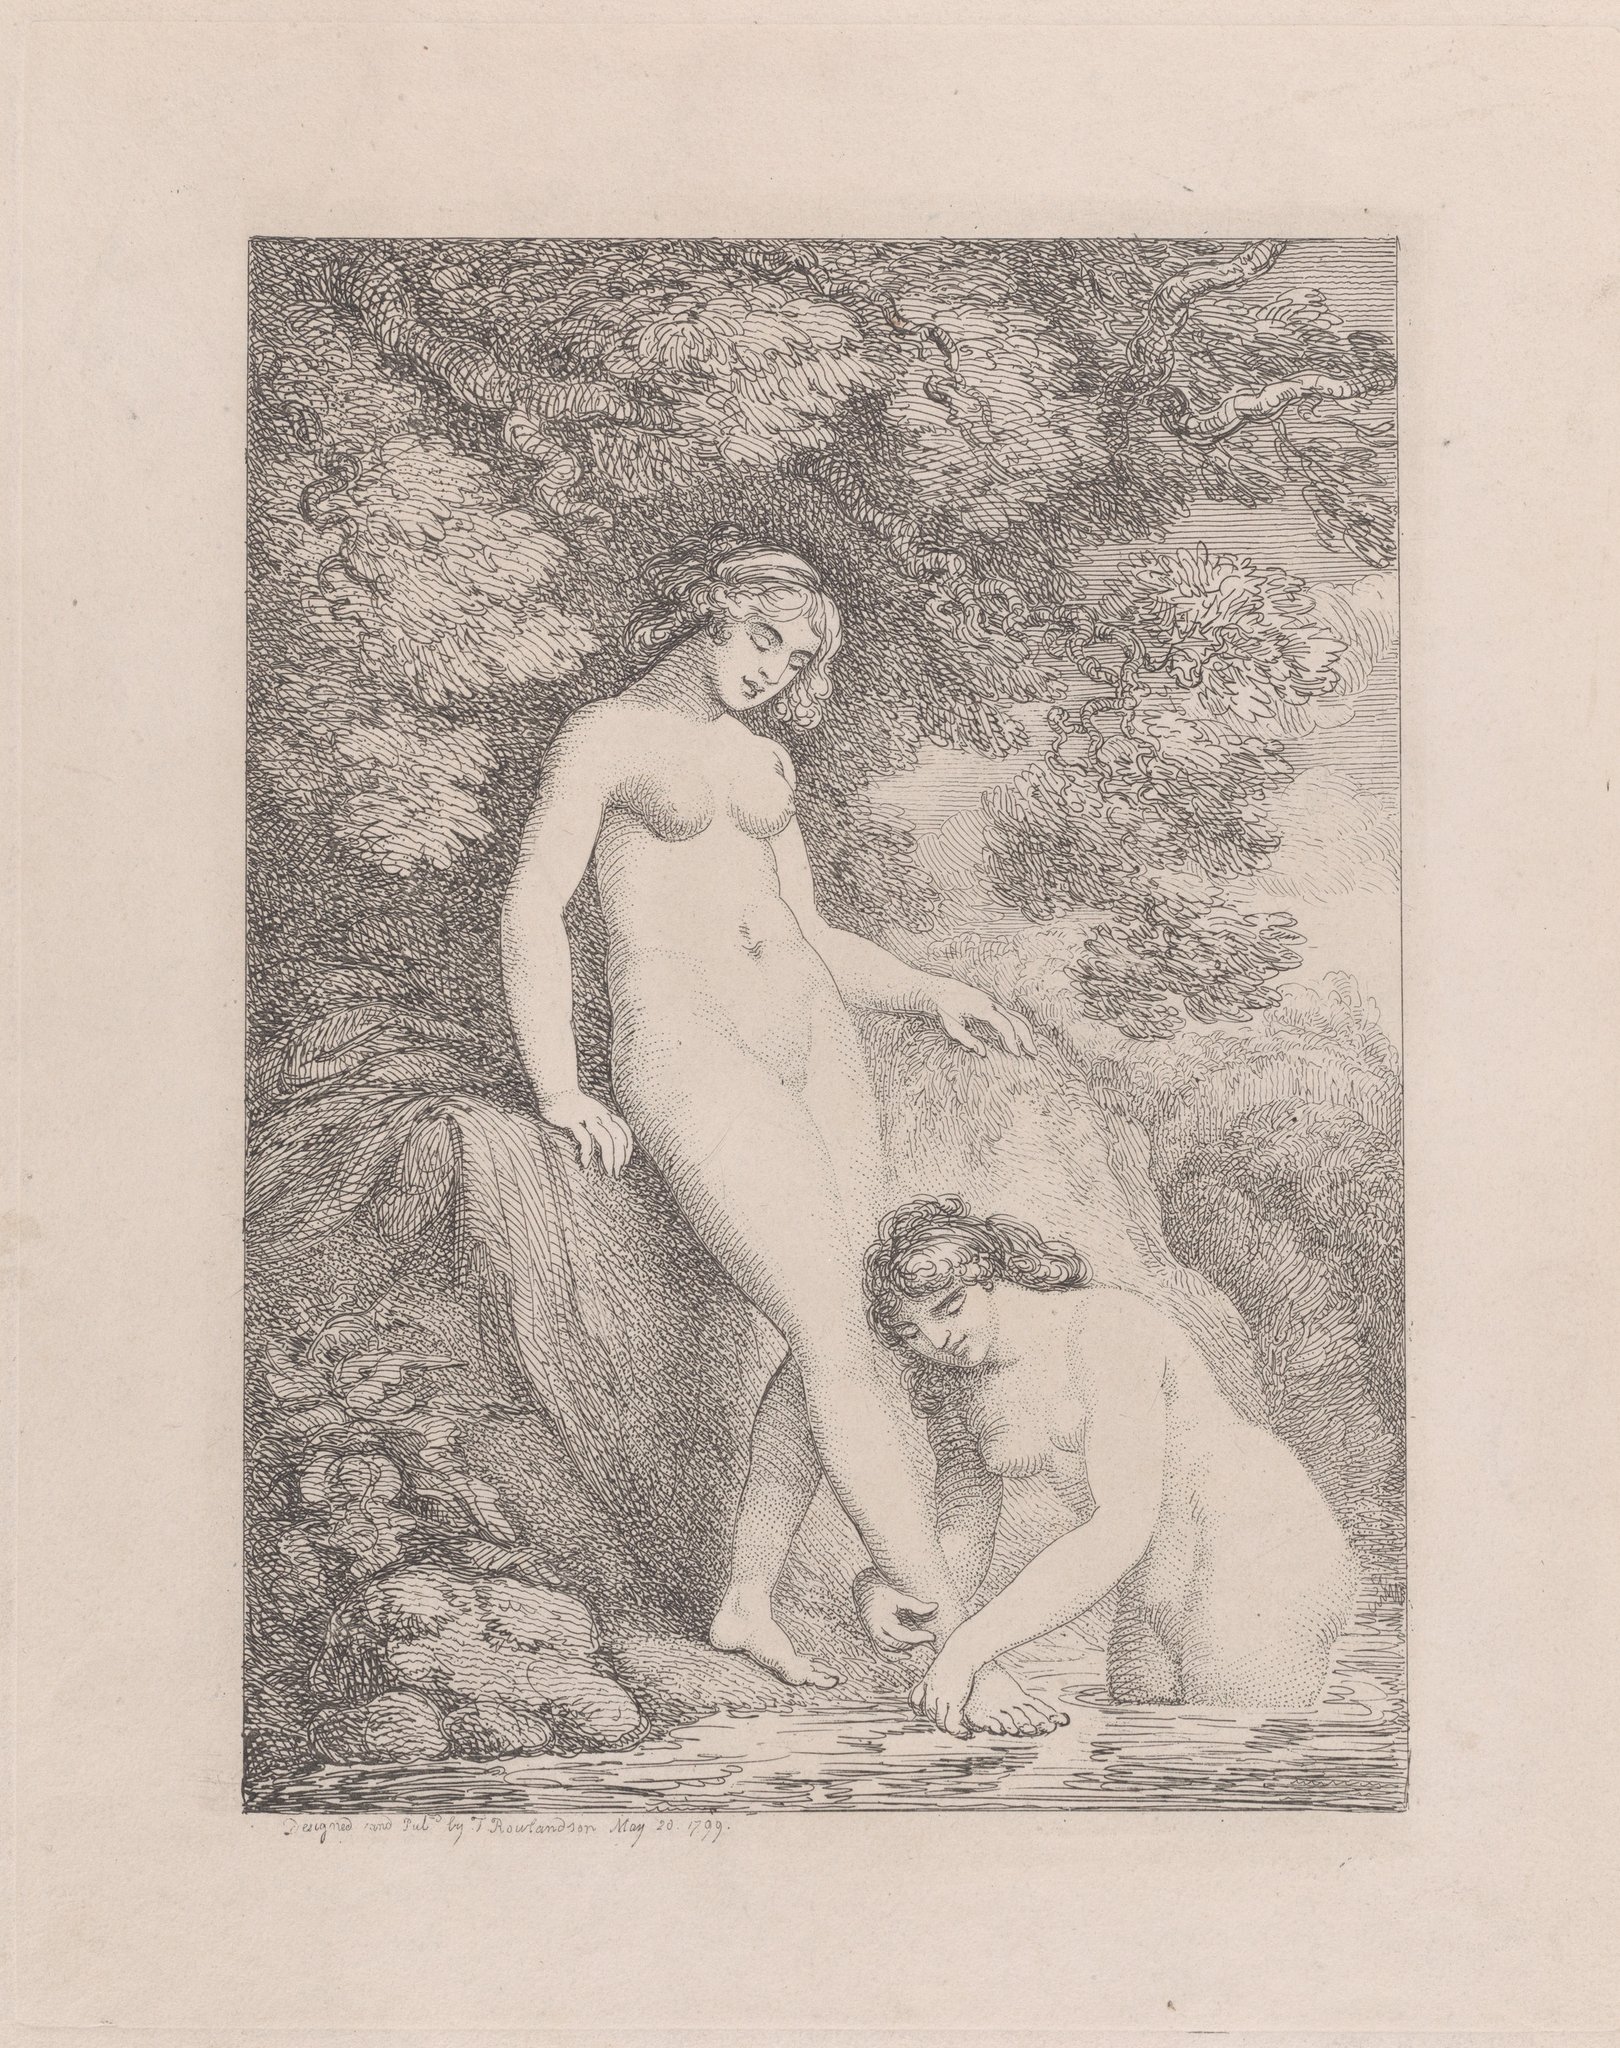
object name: print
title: Two Nymphs Bathing, One Washing the Other's Foot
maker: thomas rowlandson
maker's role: artist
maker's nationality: british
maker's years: 1757-1827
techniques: etching, stippling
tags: female nudes,nymphs